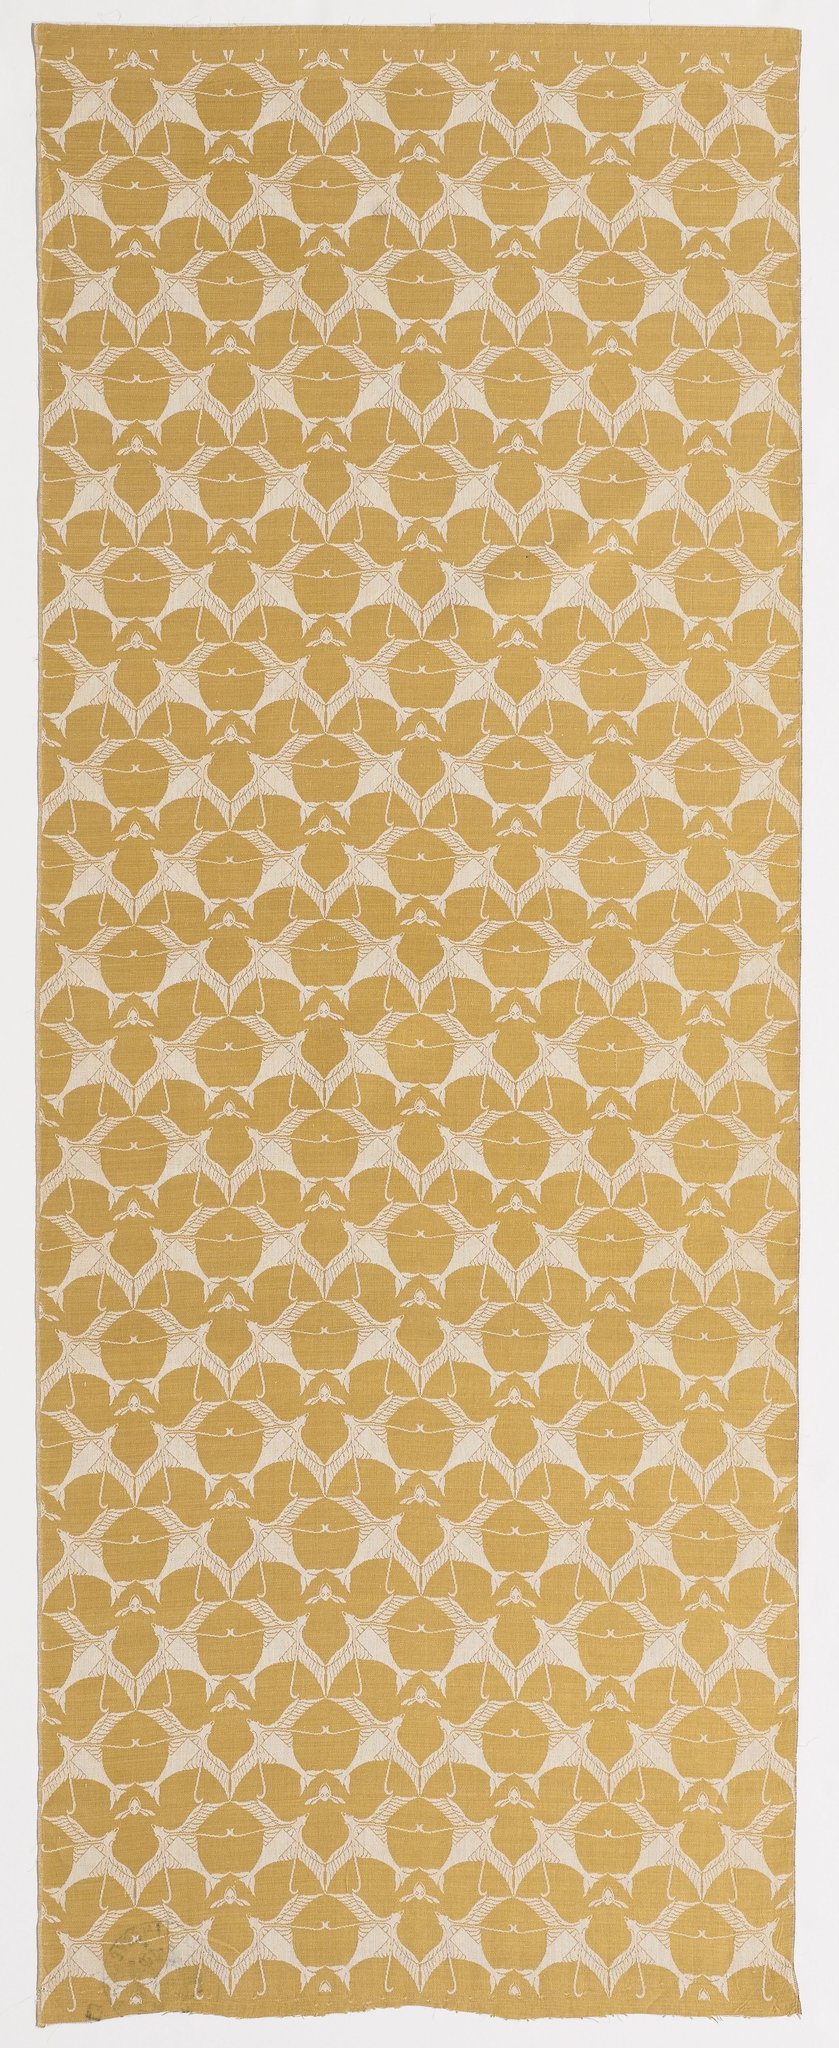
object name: upholstered wall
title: Wandbespanning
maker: chris lebeau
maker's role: draughtsman, print maker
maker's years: 1878-1945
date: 1911-1915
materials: linen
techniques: damask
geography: eindhoven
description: Goudgele damasten wandbespanning met een jachttafreel.